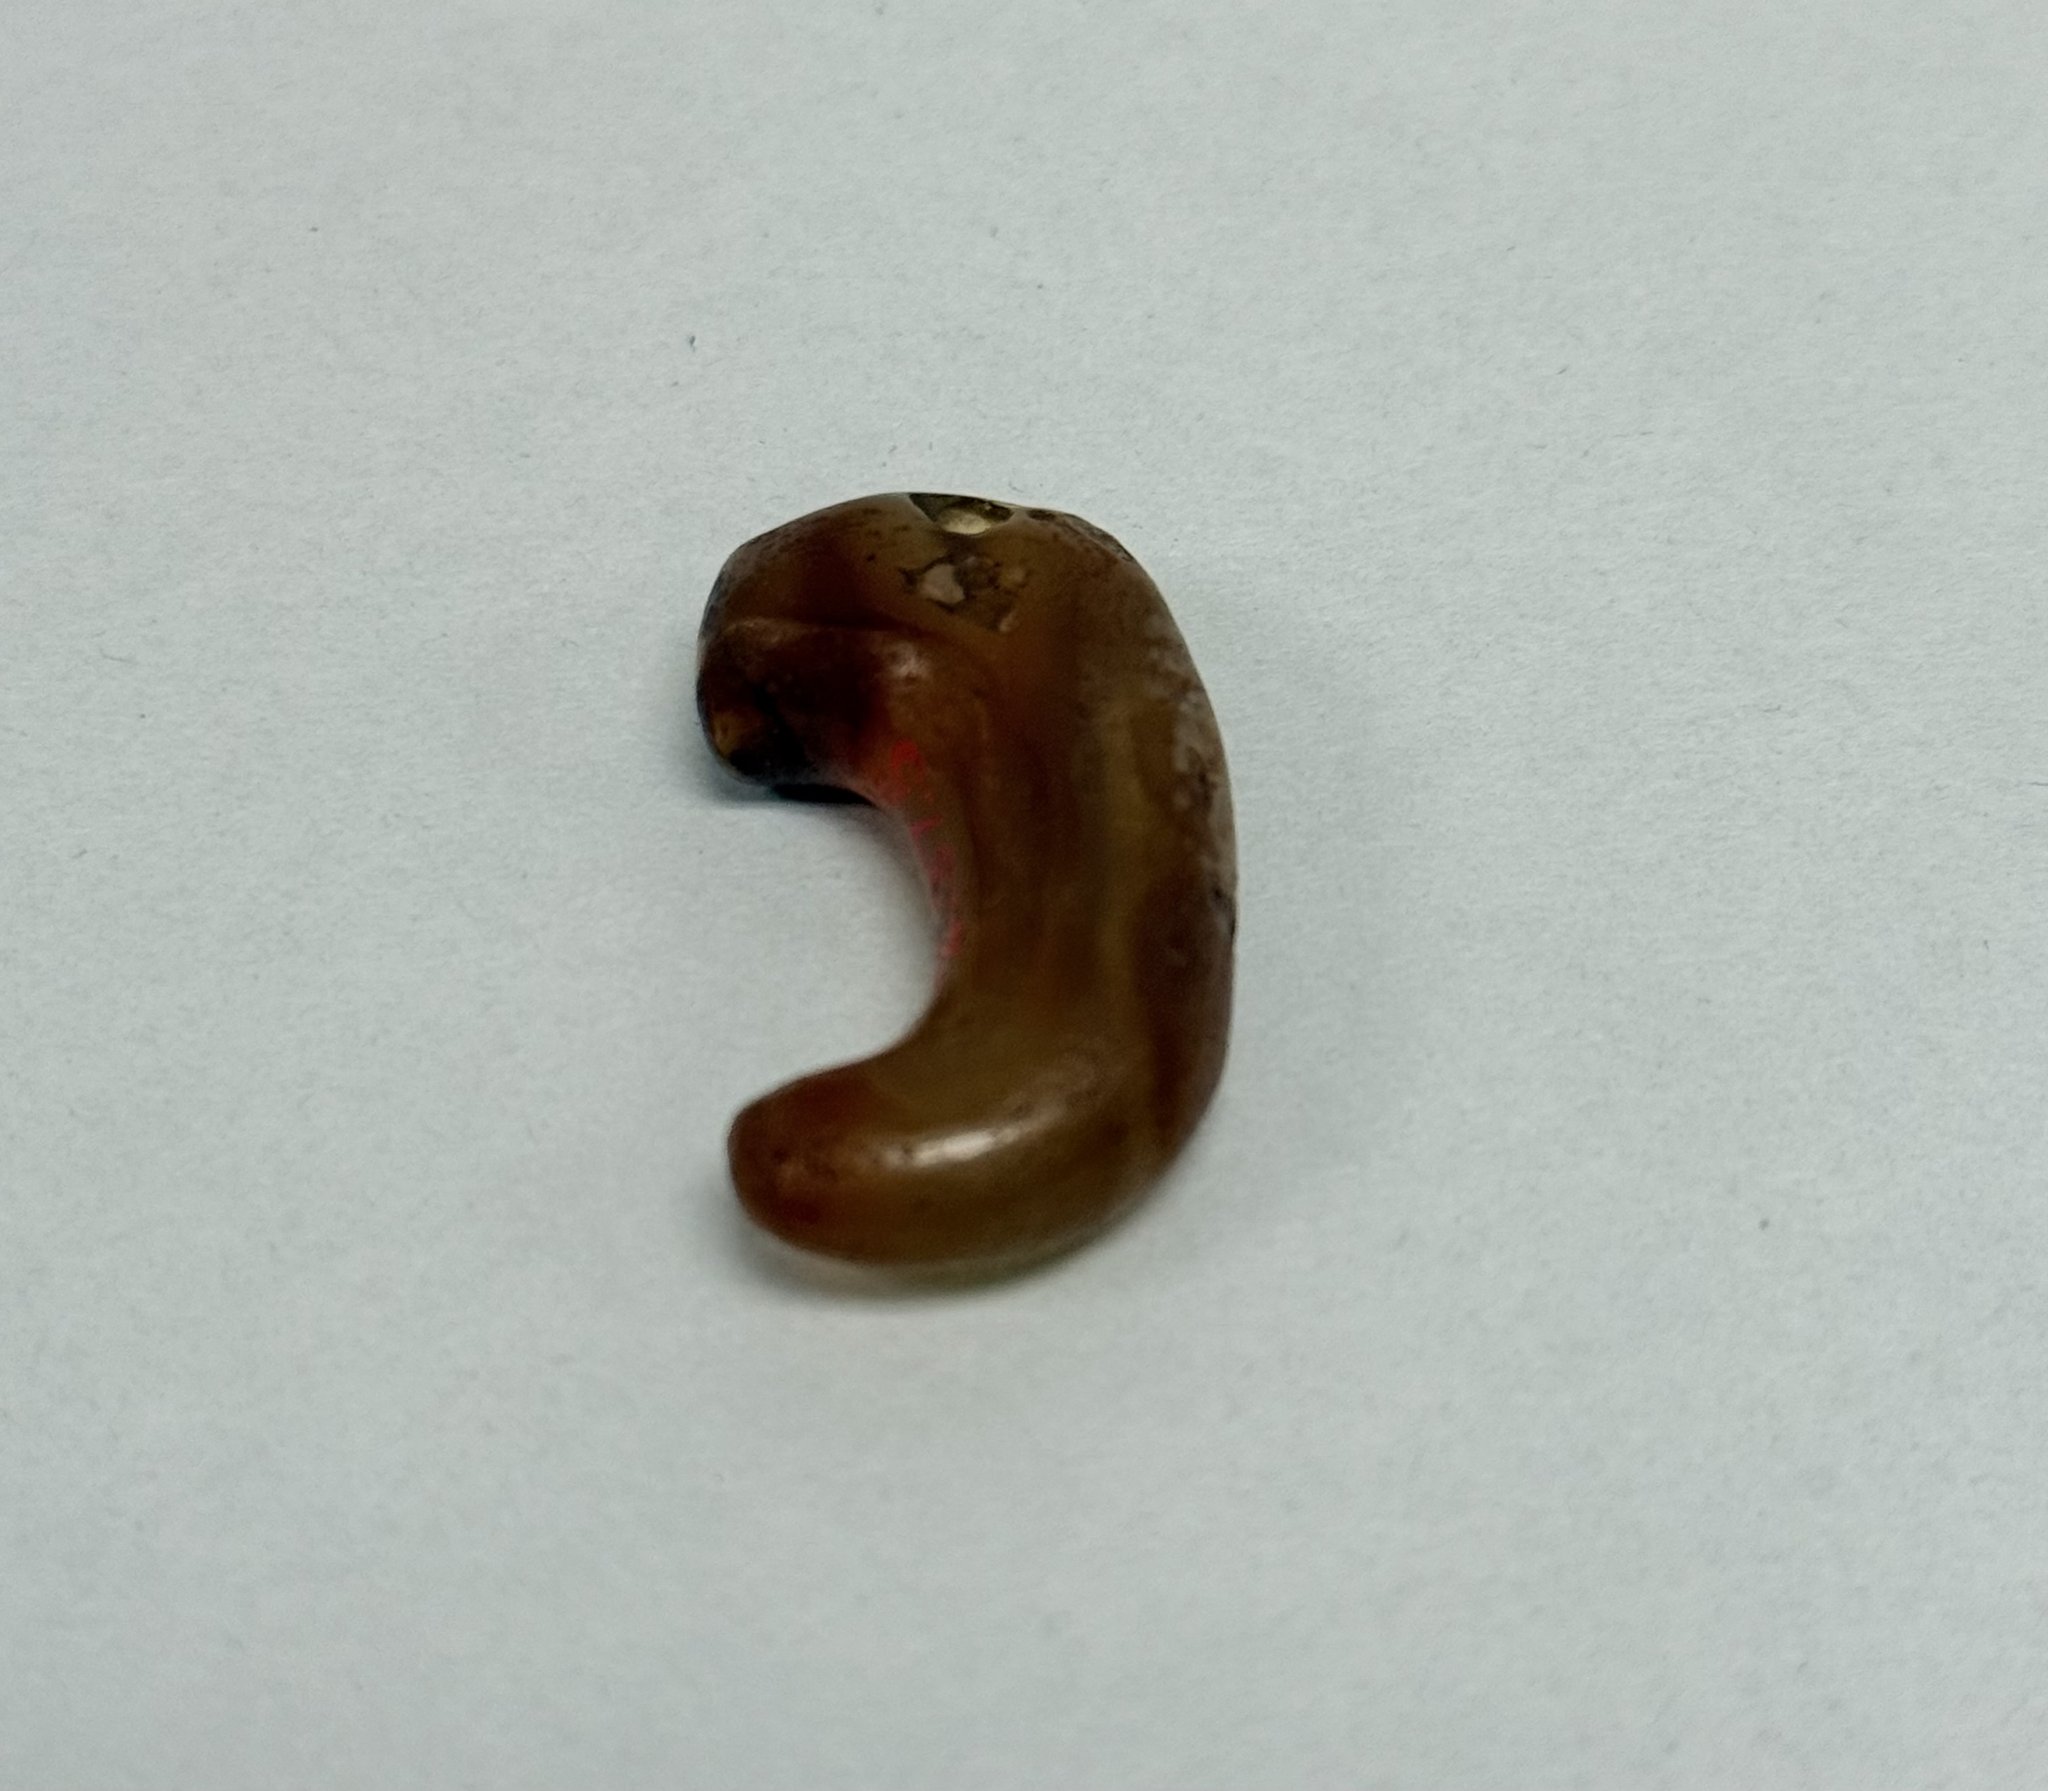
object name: jewel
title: Tiger Claw Jewel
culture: japanese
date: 601-700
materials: stone